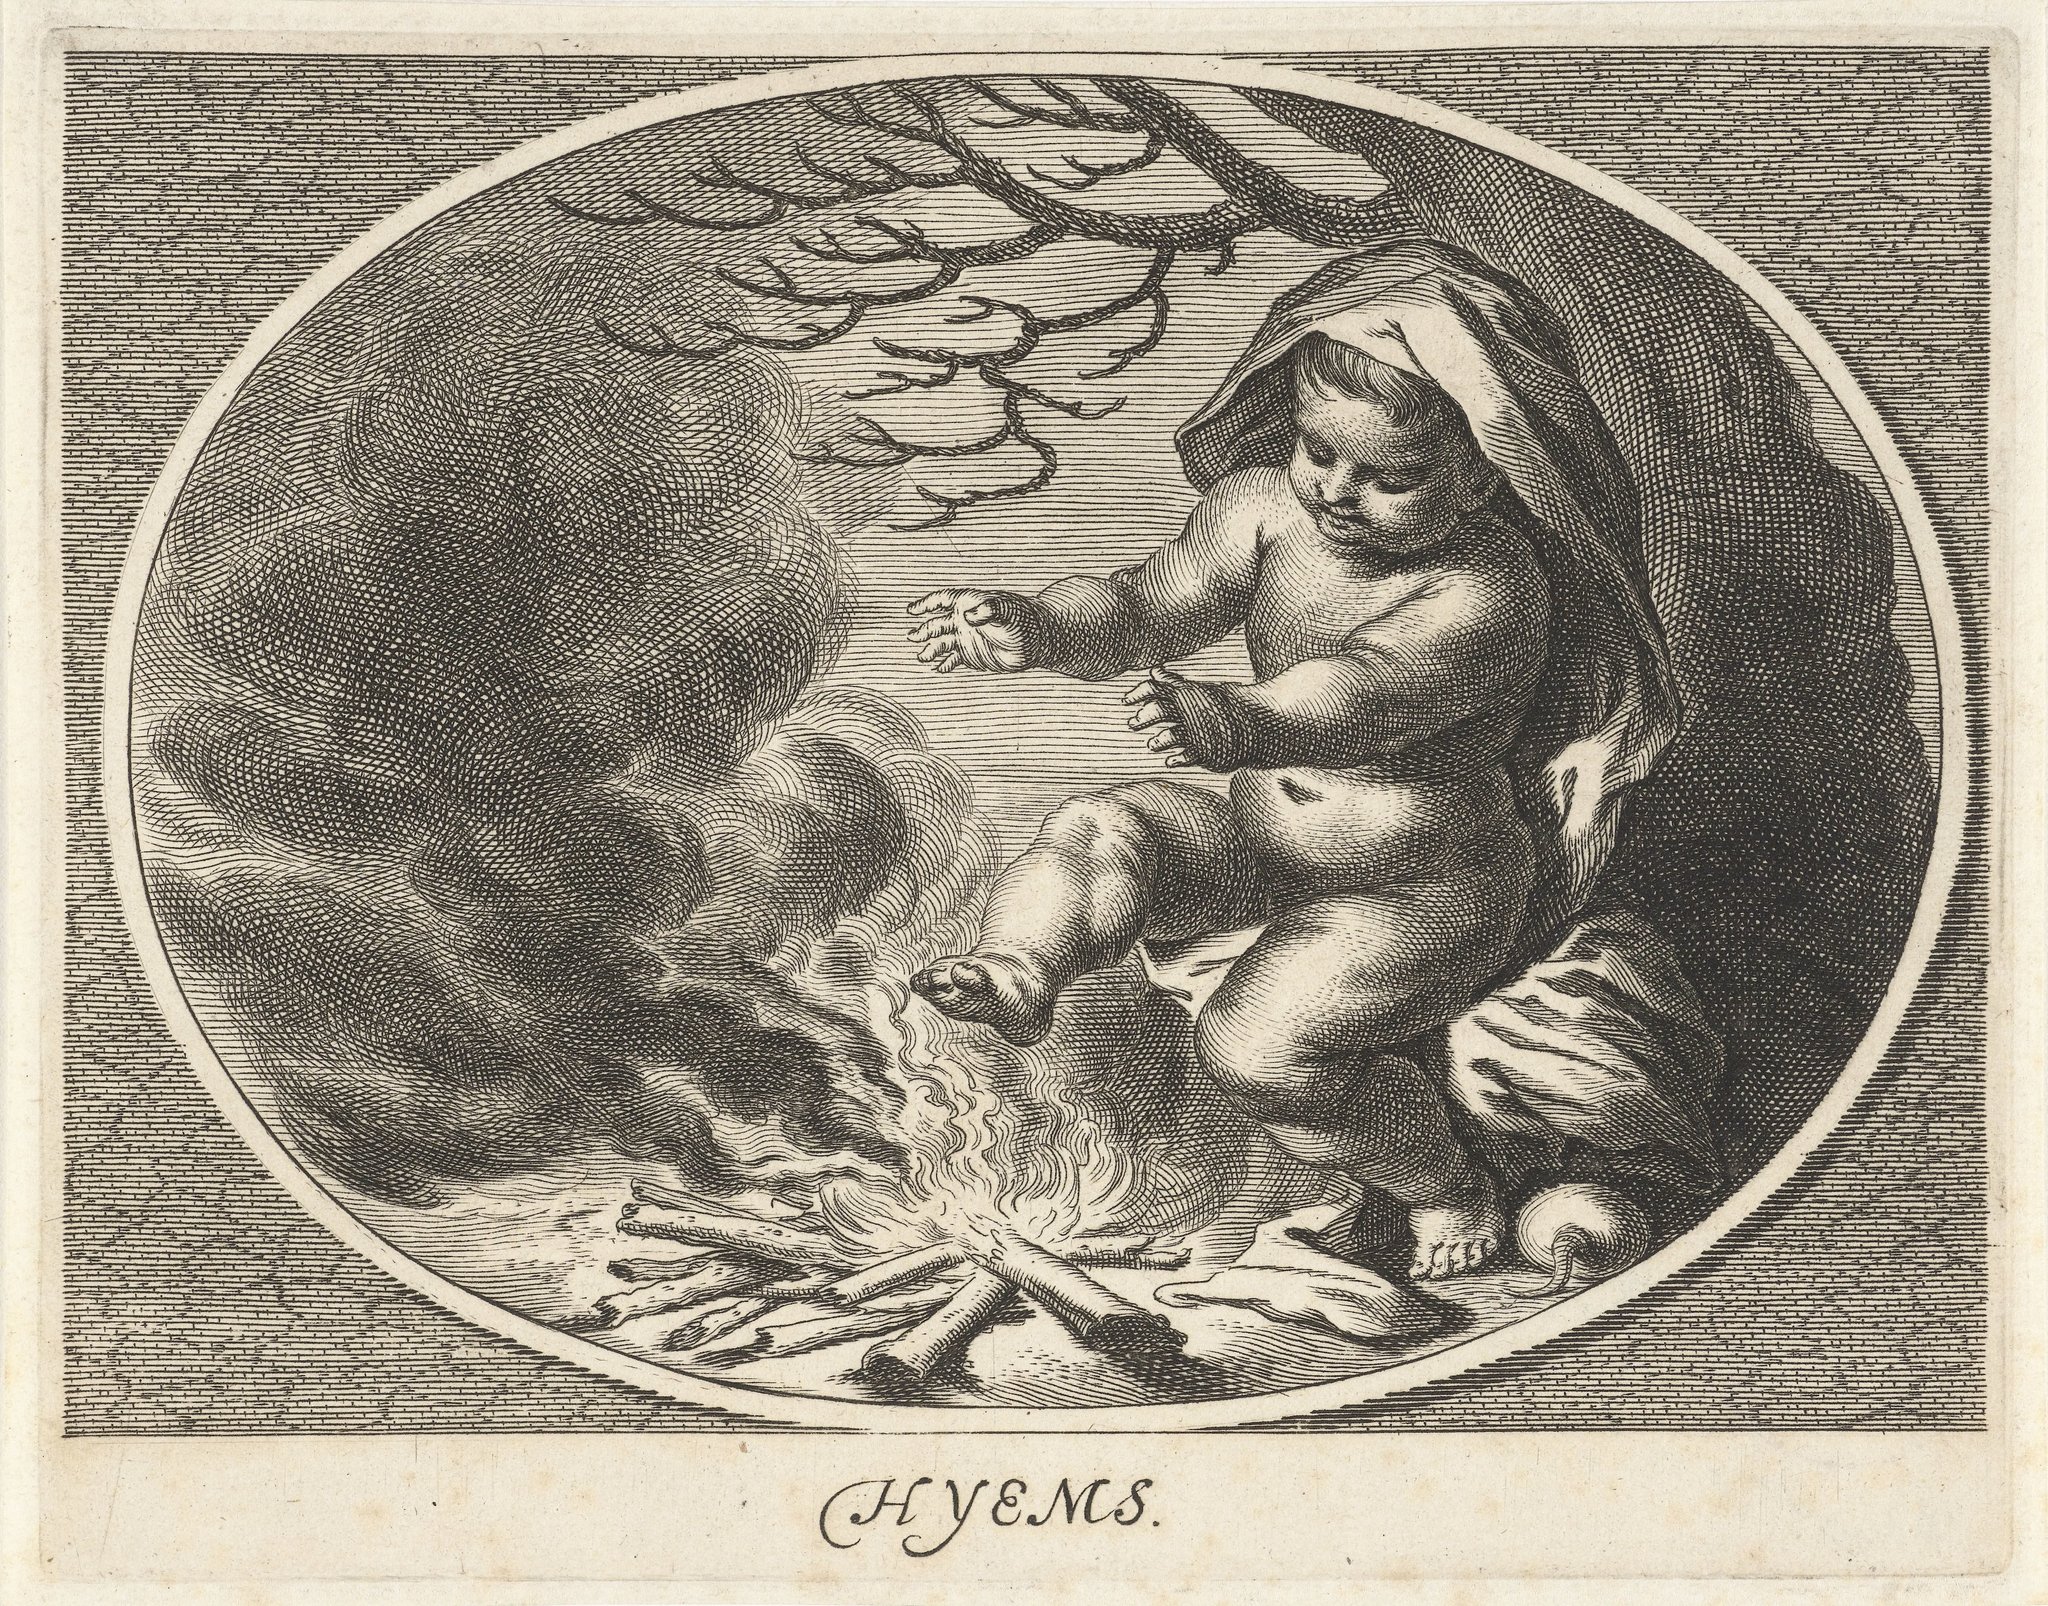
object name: print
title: Hyems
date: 1648-1664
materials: paper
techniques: engraving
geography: amsterdam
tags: winter, 'hyems'; 'inverno' (ripa)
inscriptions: collector's mark: Lugt 240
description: Prent uit serie van vier prenten met de vier jaargetijden.